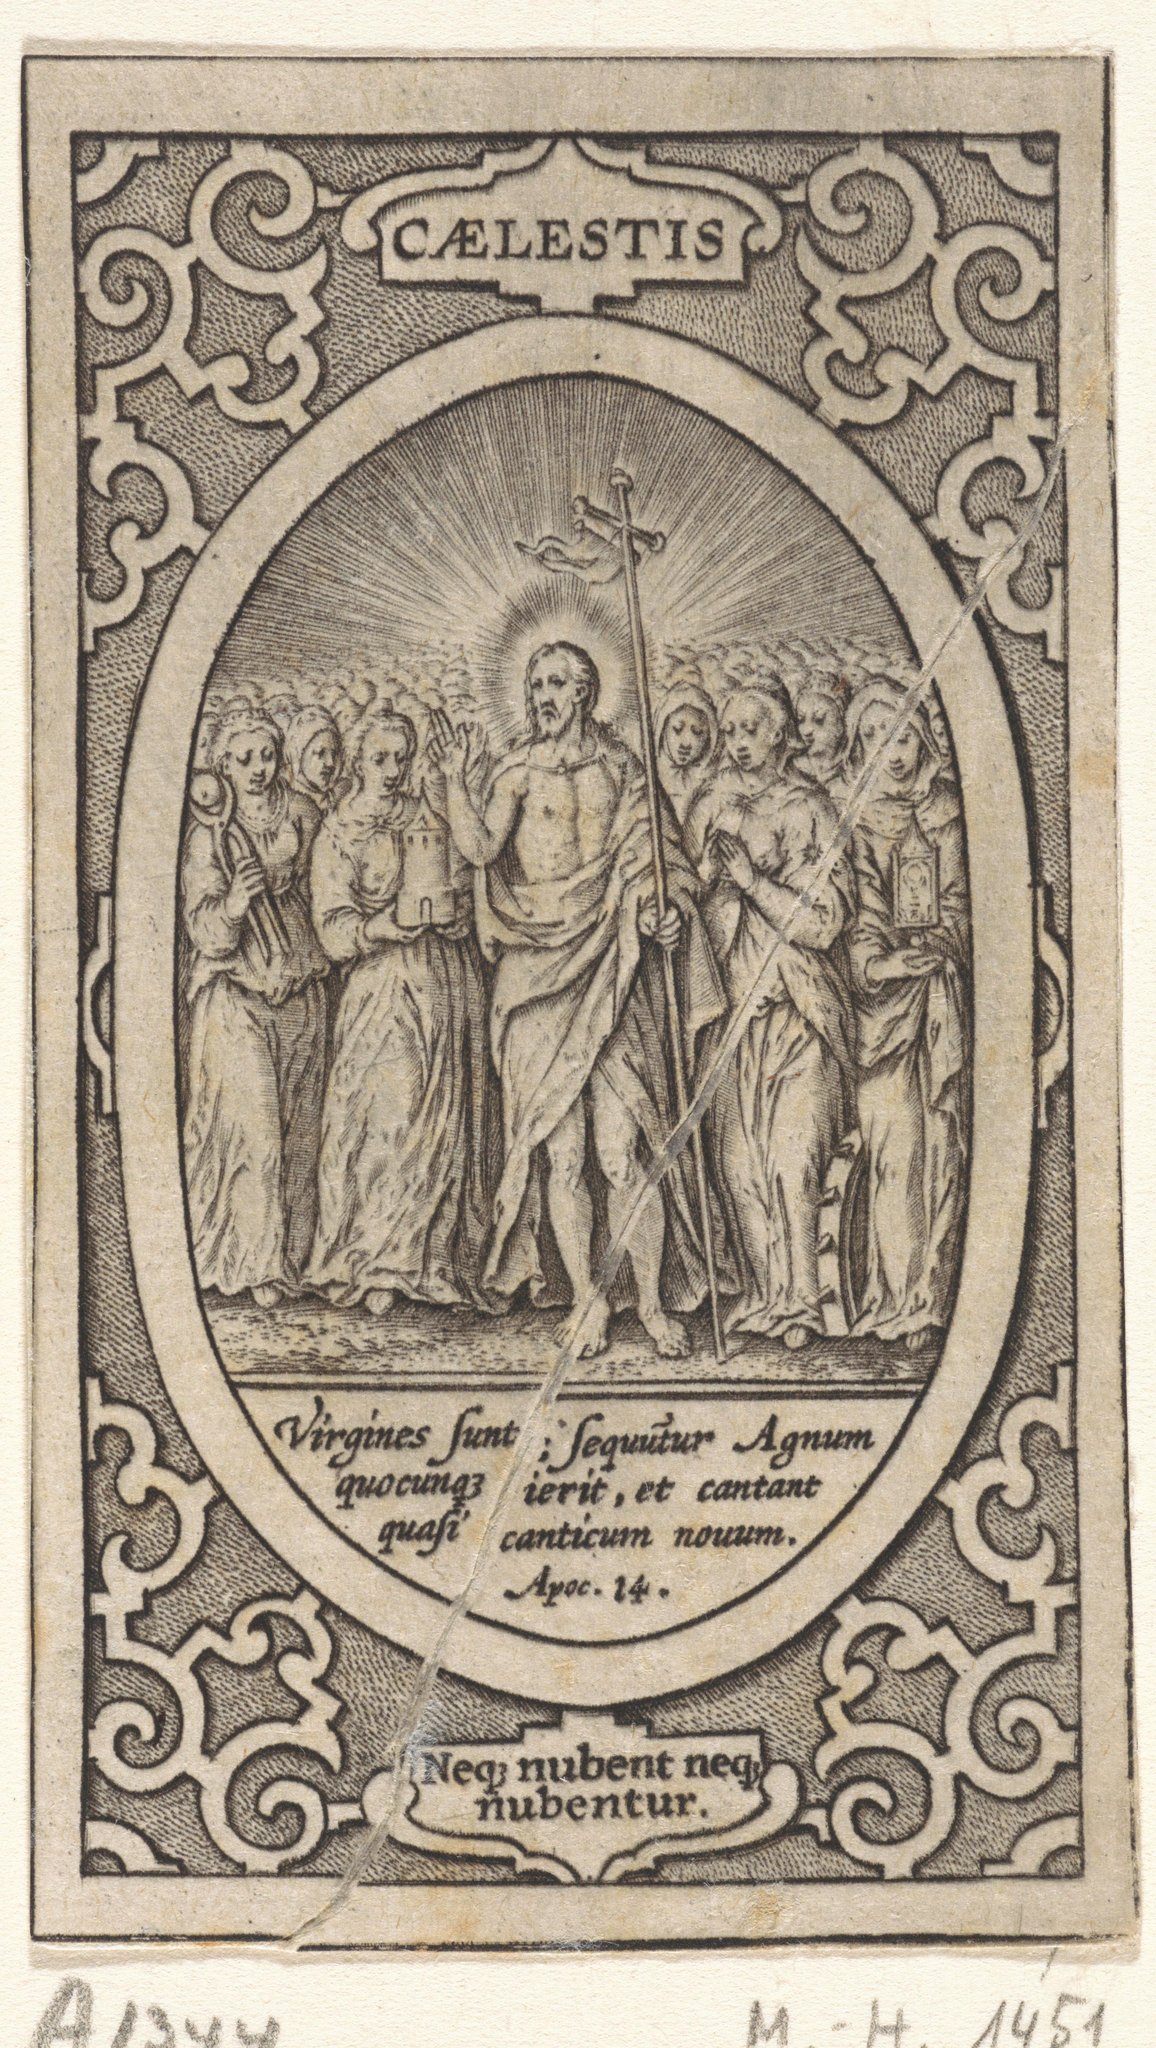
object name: print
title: Christus in de hemel (Caelestis)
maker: hieronymus wierix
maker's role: draughtsman, print maker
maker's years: 1553-1619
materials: paper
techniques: engraving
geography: antwerp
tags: adult christ together with apostles, evangelists, saints, etc.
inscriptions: collector's mark: Lugt 2773, collector's mark: Lugt 2228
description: De prent is een fragment van een prent die oorspronkelijk bestaat uit een voorstelling van Maria met het Christuskind, omringd door scènes die deugdzaamheid illustreren.